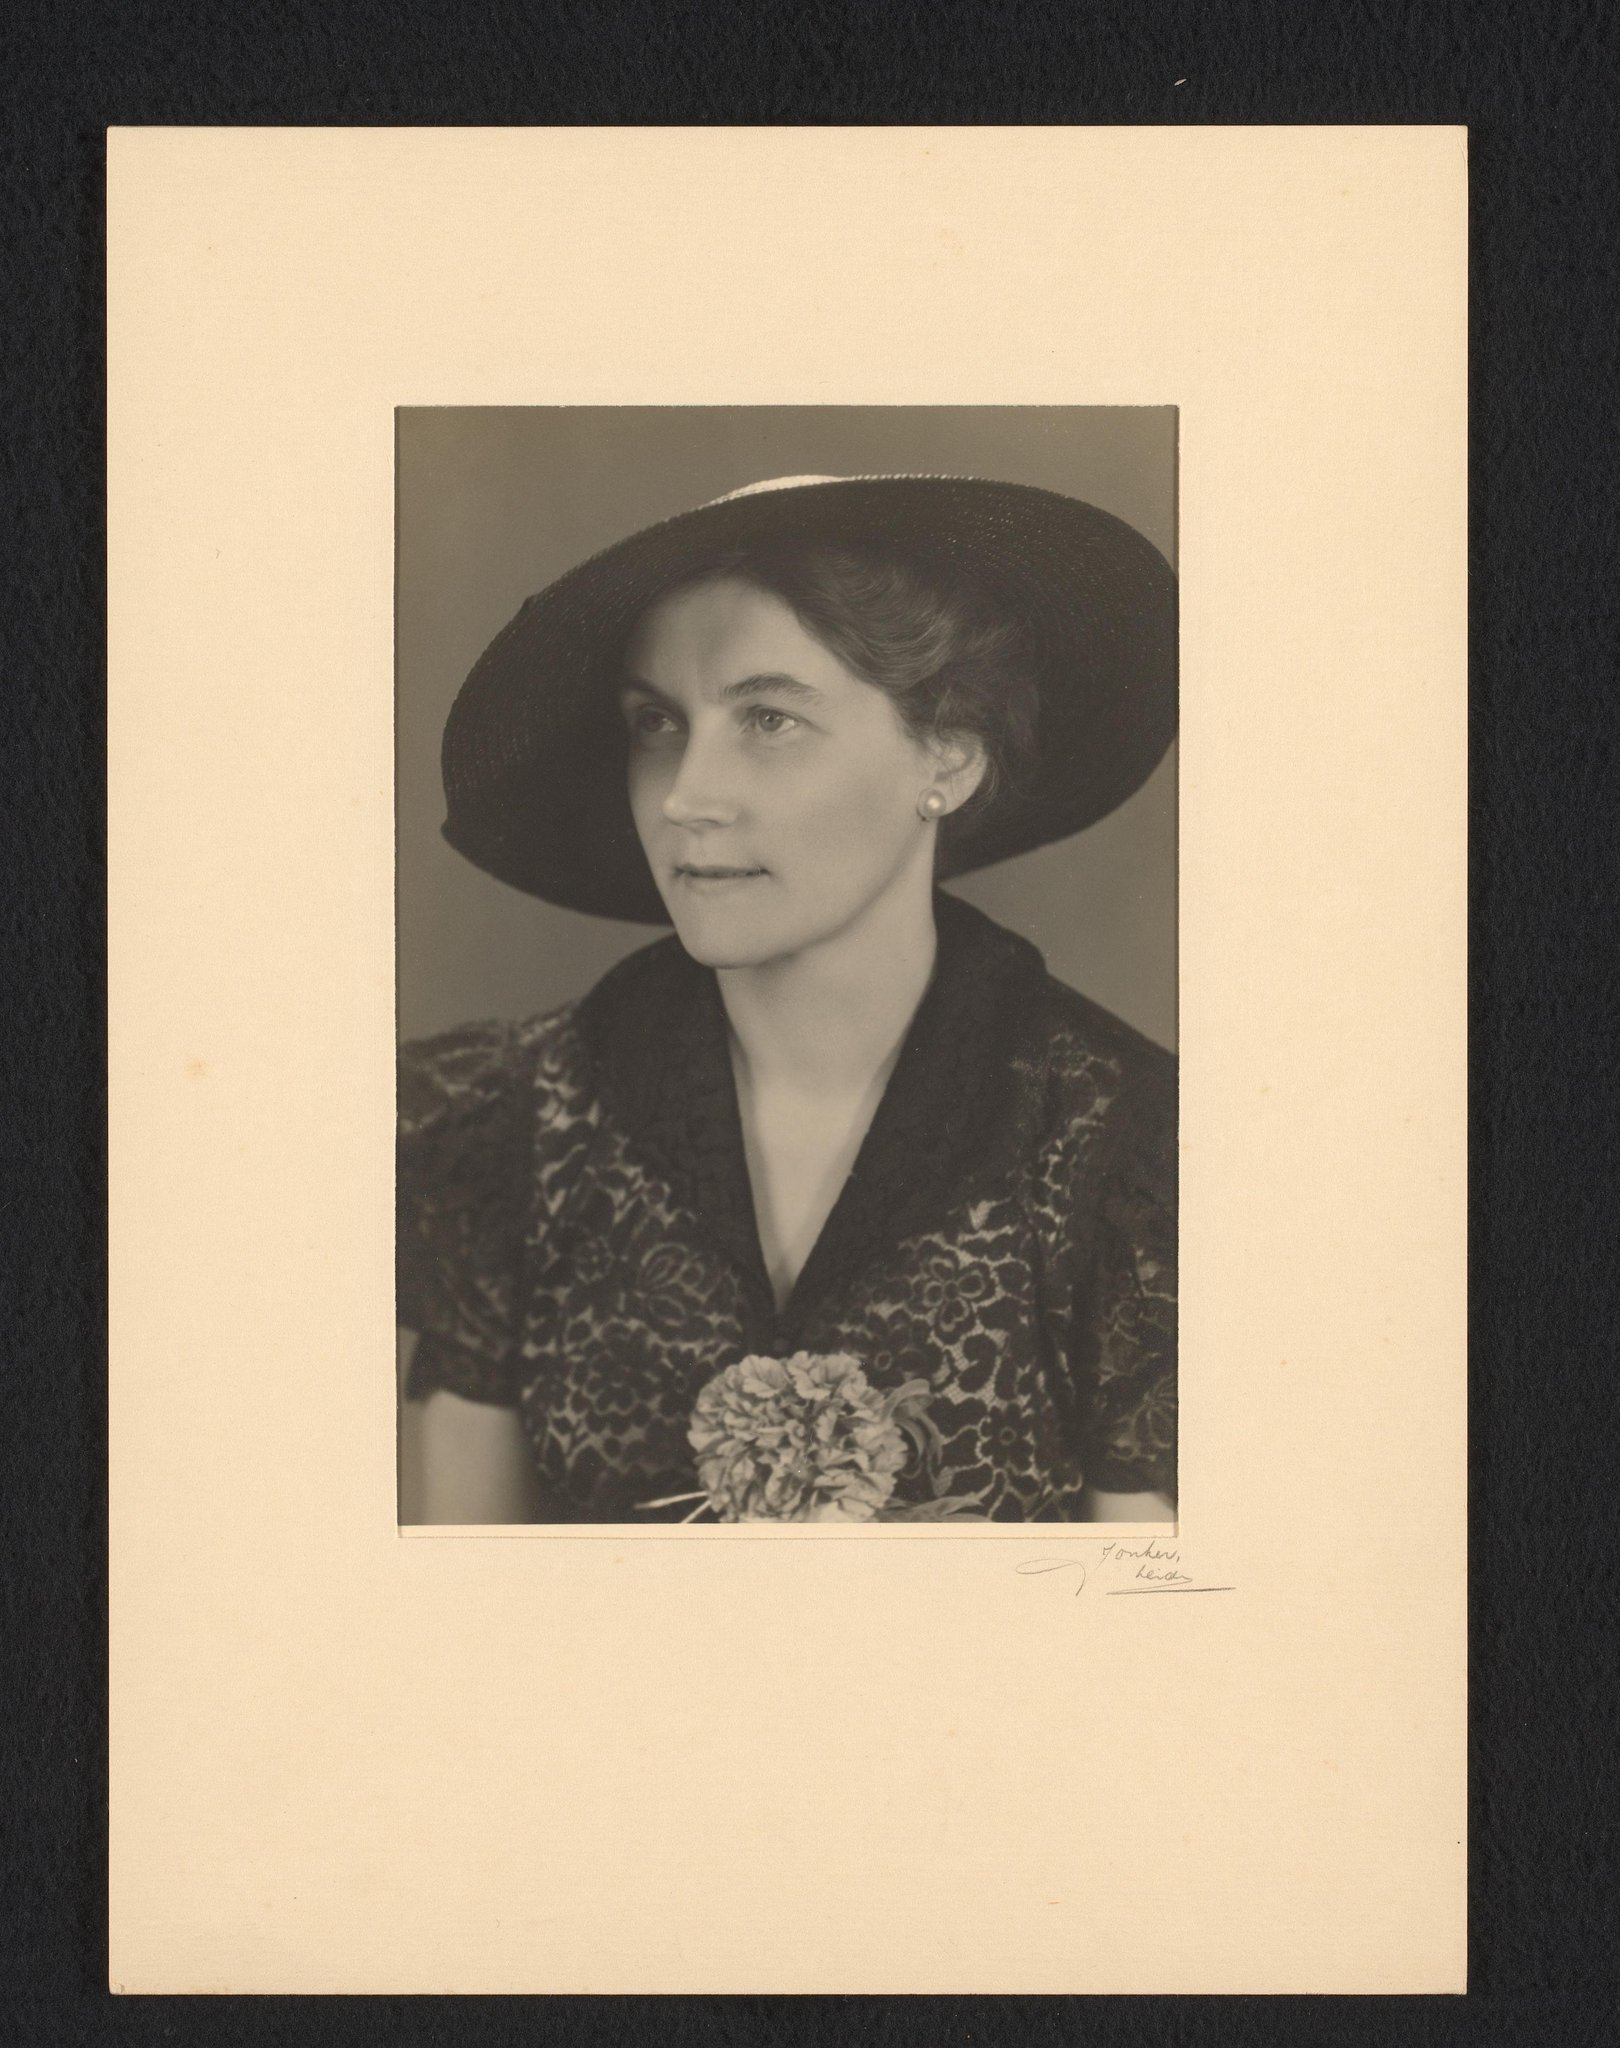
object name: photograph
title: Portret van Johanna (Hans) Stokhuyzen-de Jong als volwassen vrouw, met hoed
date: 1938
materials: paper, cardboard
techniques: gelatin silver print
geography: leiden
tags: leiden, johanna petronella lambertina stokhuyzen-de jong (hans), historical persons - bb - woman, head-gear: hat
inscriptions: date: ‘1938’, inscription: ‘Joh' Pet' Lamb'/ Stokhuyzen-de Jong/ +- 1930??’